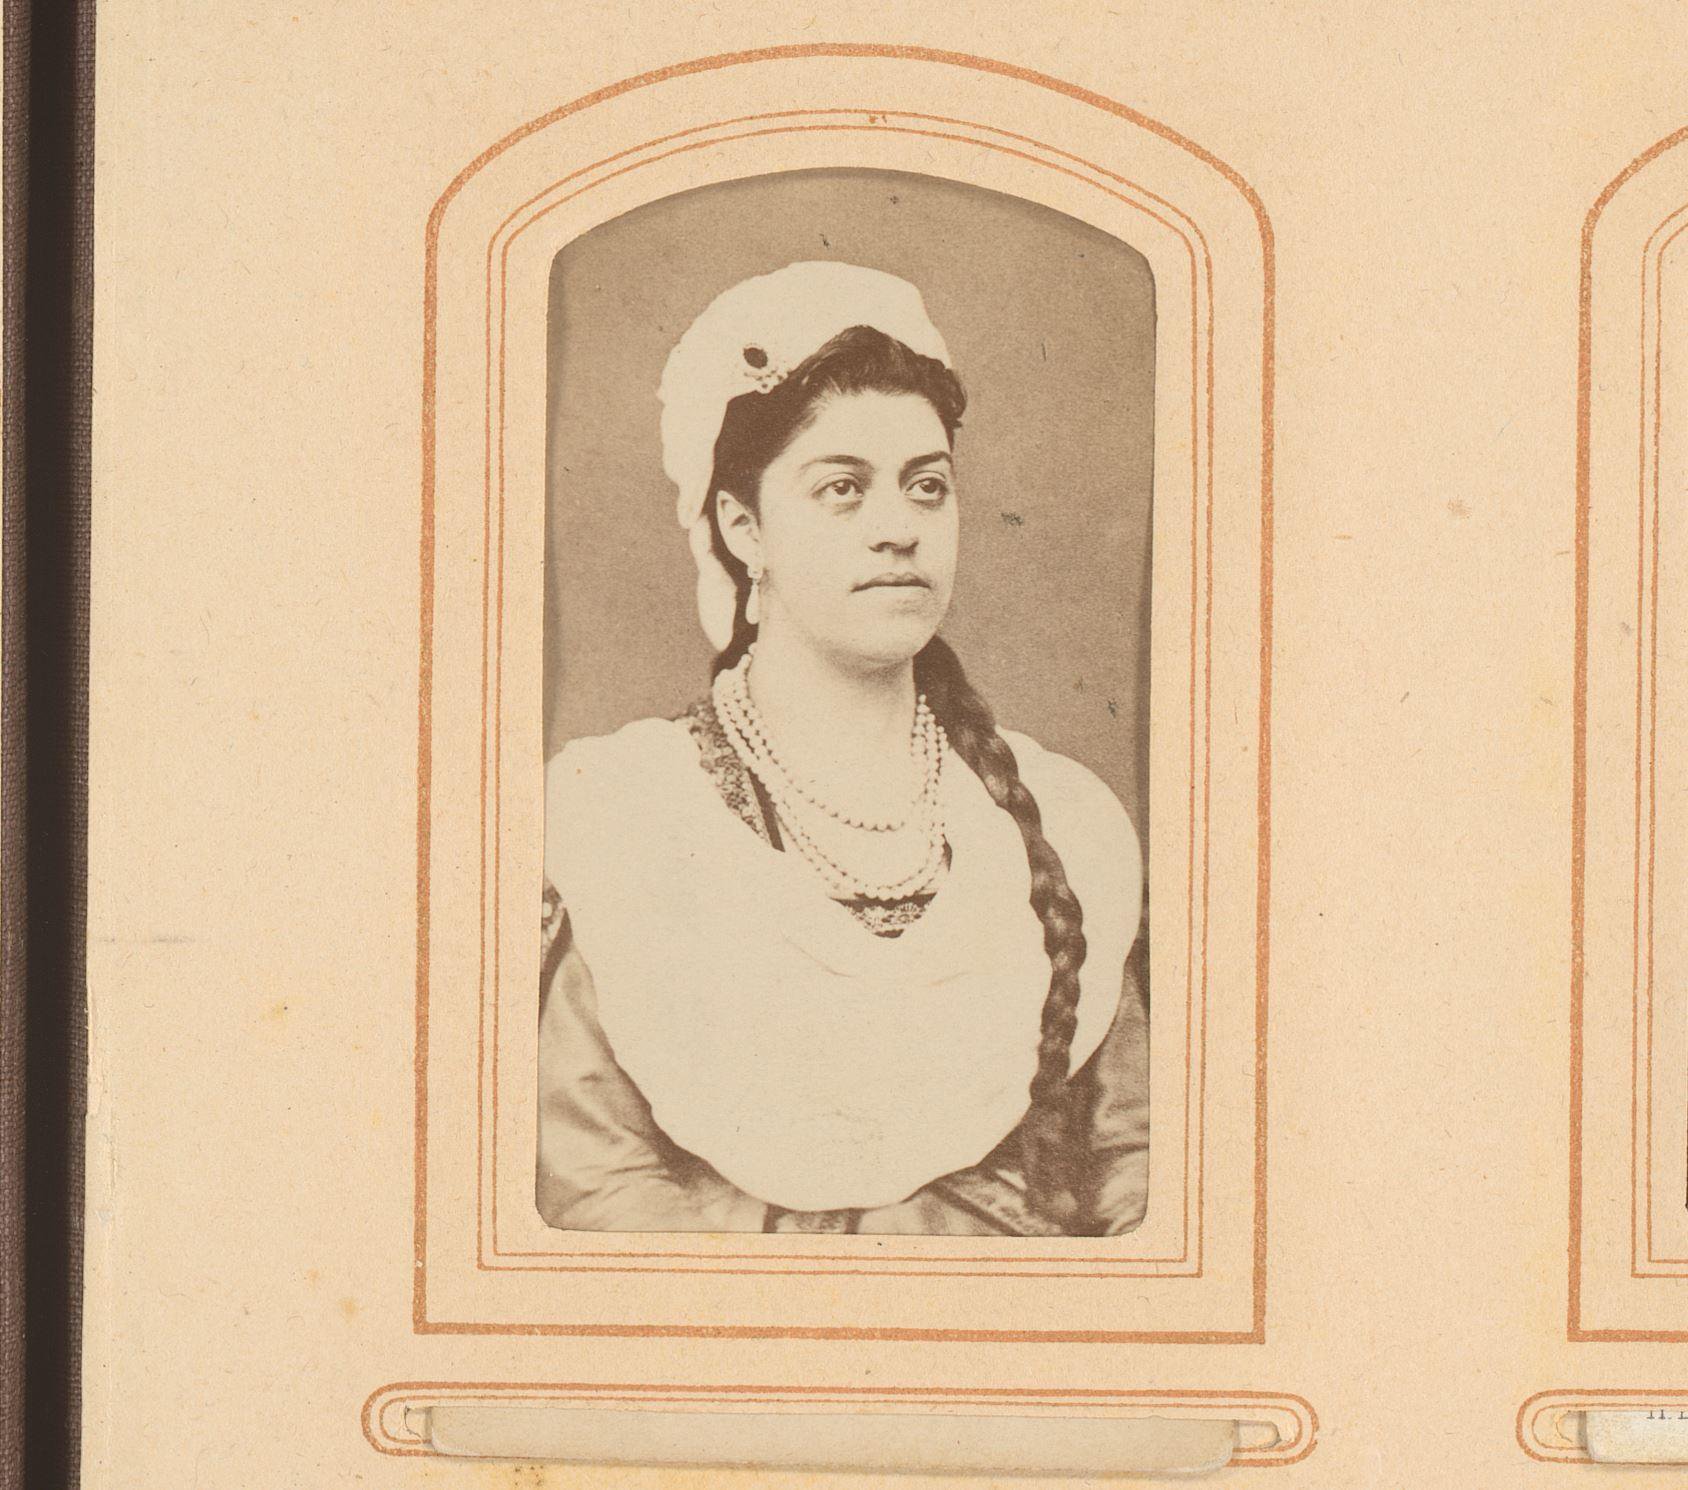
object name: photograph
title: Portret van Jeanette Jacobsson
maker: Anonymous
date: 1855-1890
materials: cardboard, photographic support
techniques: albumen print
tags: adult woman, portrait of artiste (dancer, actor, etc.), historical persons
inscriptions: annotation: ‘Fru Jacobsson/ Jeanette/ f. Davidsson/ 1841-1907’